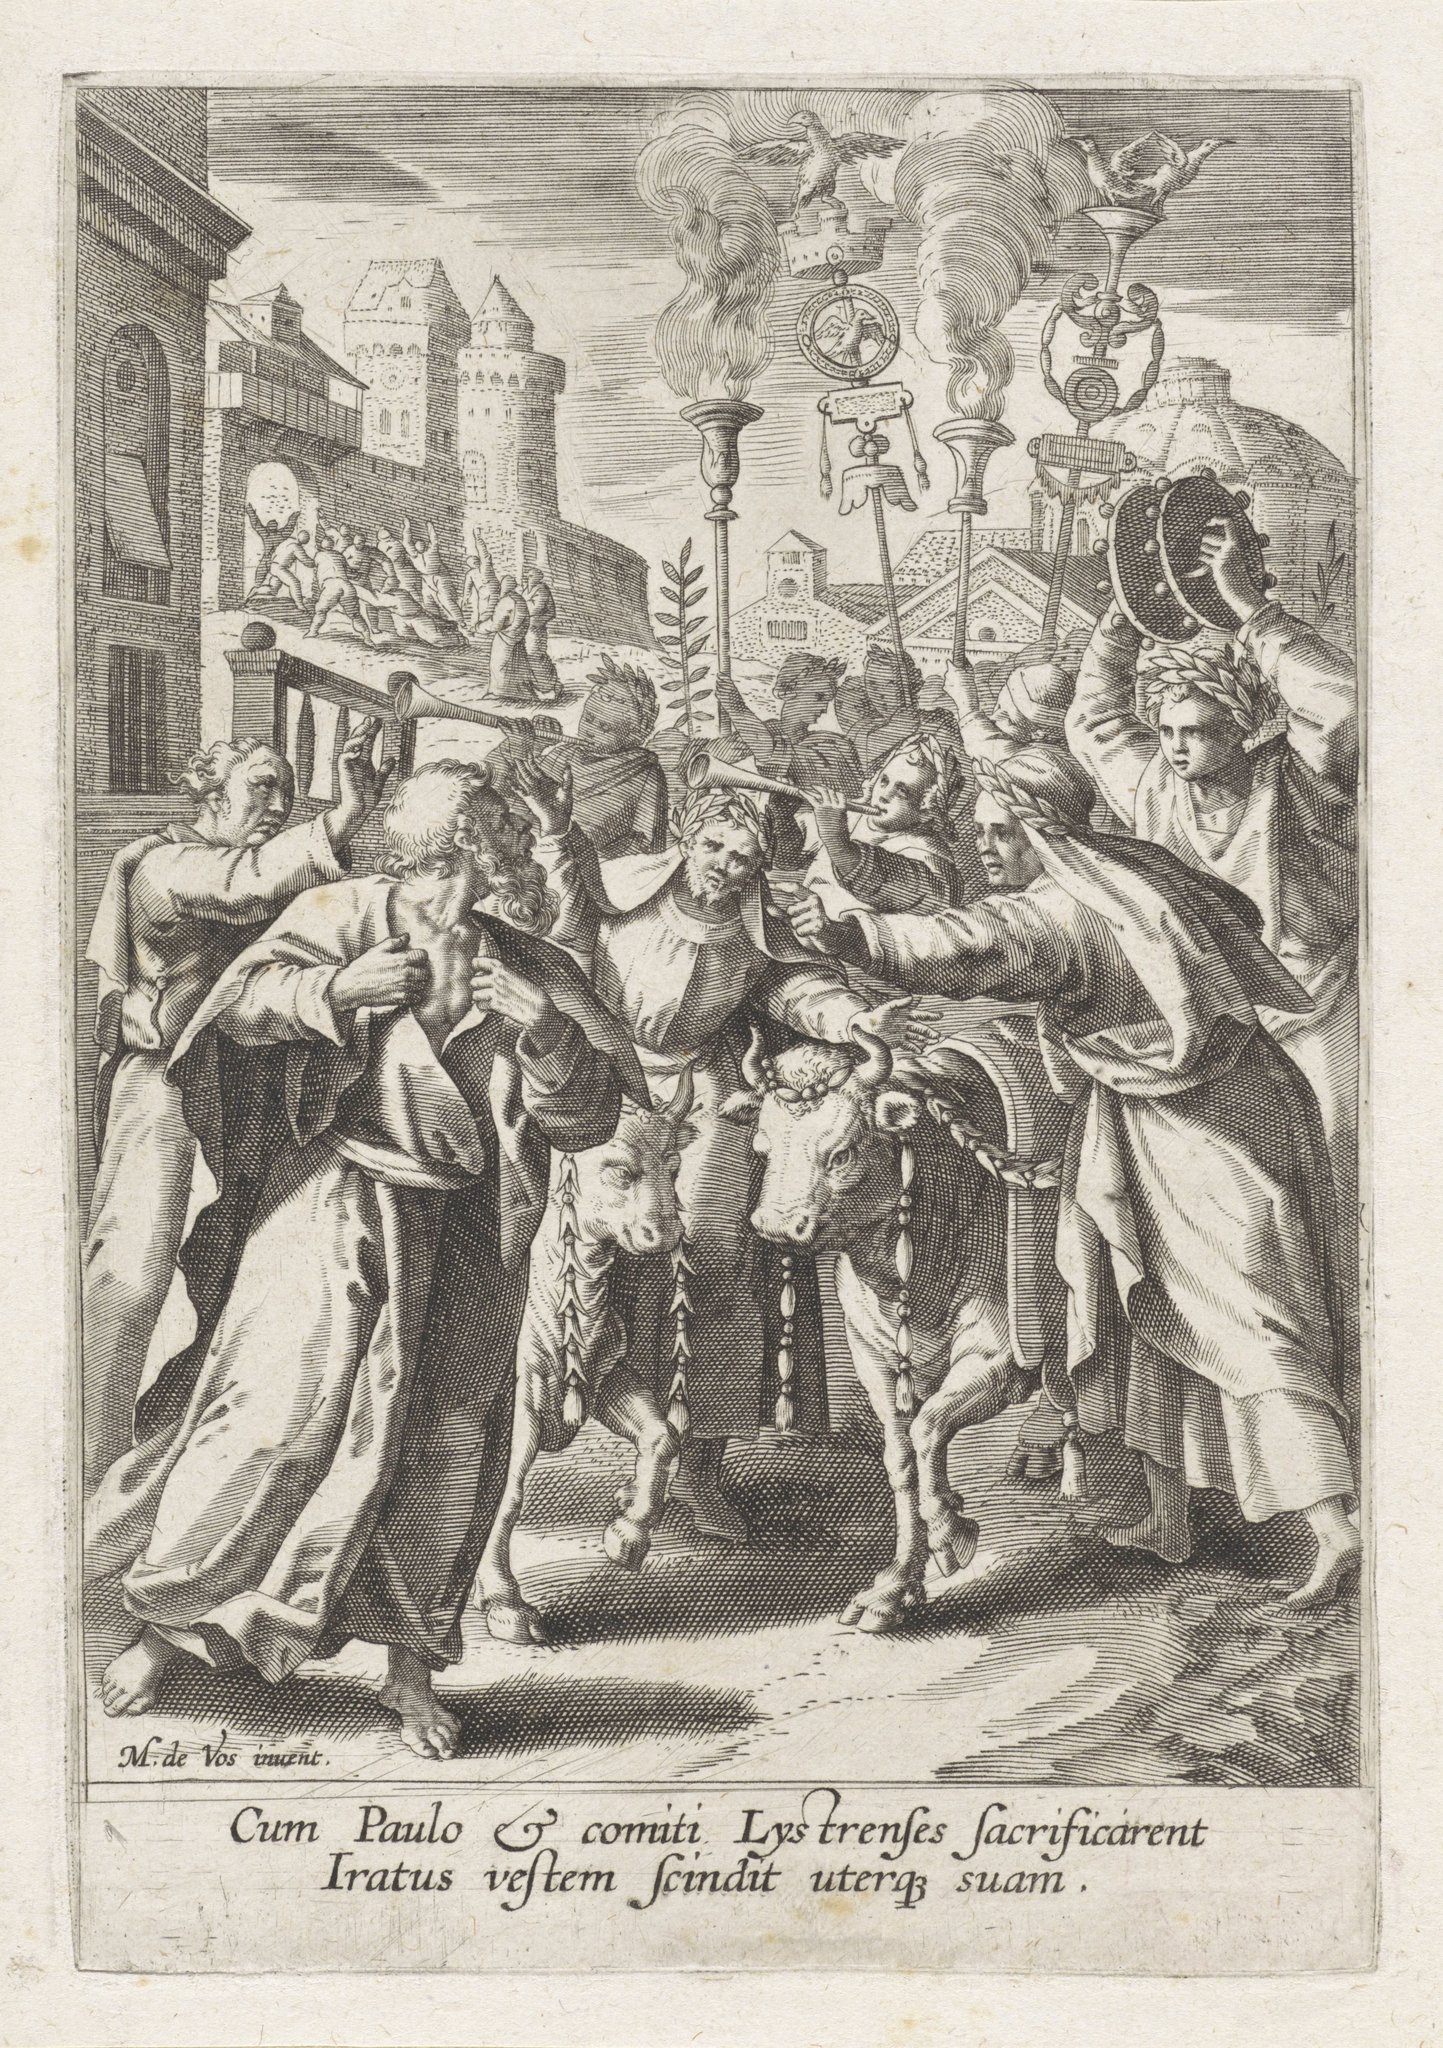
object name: print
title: Handelingen van de apostelen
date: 1591-1600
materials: paper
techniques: engraving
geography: antwerp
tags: paul and barnabas tear their clothes, and try to prevent the sacrifice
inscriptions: collector's mark: Lugt 240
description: Paulus en Barnabas genazen een man die niet kon lopen. De priester van de tempel van Jupiter en zijn volgers wilden stieren als geschenk offeren, omdat ze in de veronderstelling waren dat Paulus en Barnabas Mercurius en Jupiter in menselijke gedaante waren. Paulus verscheurt ontzet zijn kleren om dit te voorkomen. Onder in de marge een tweeregelig onderschrift in het Latijn.